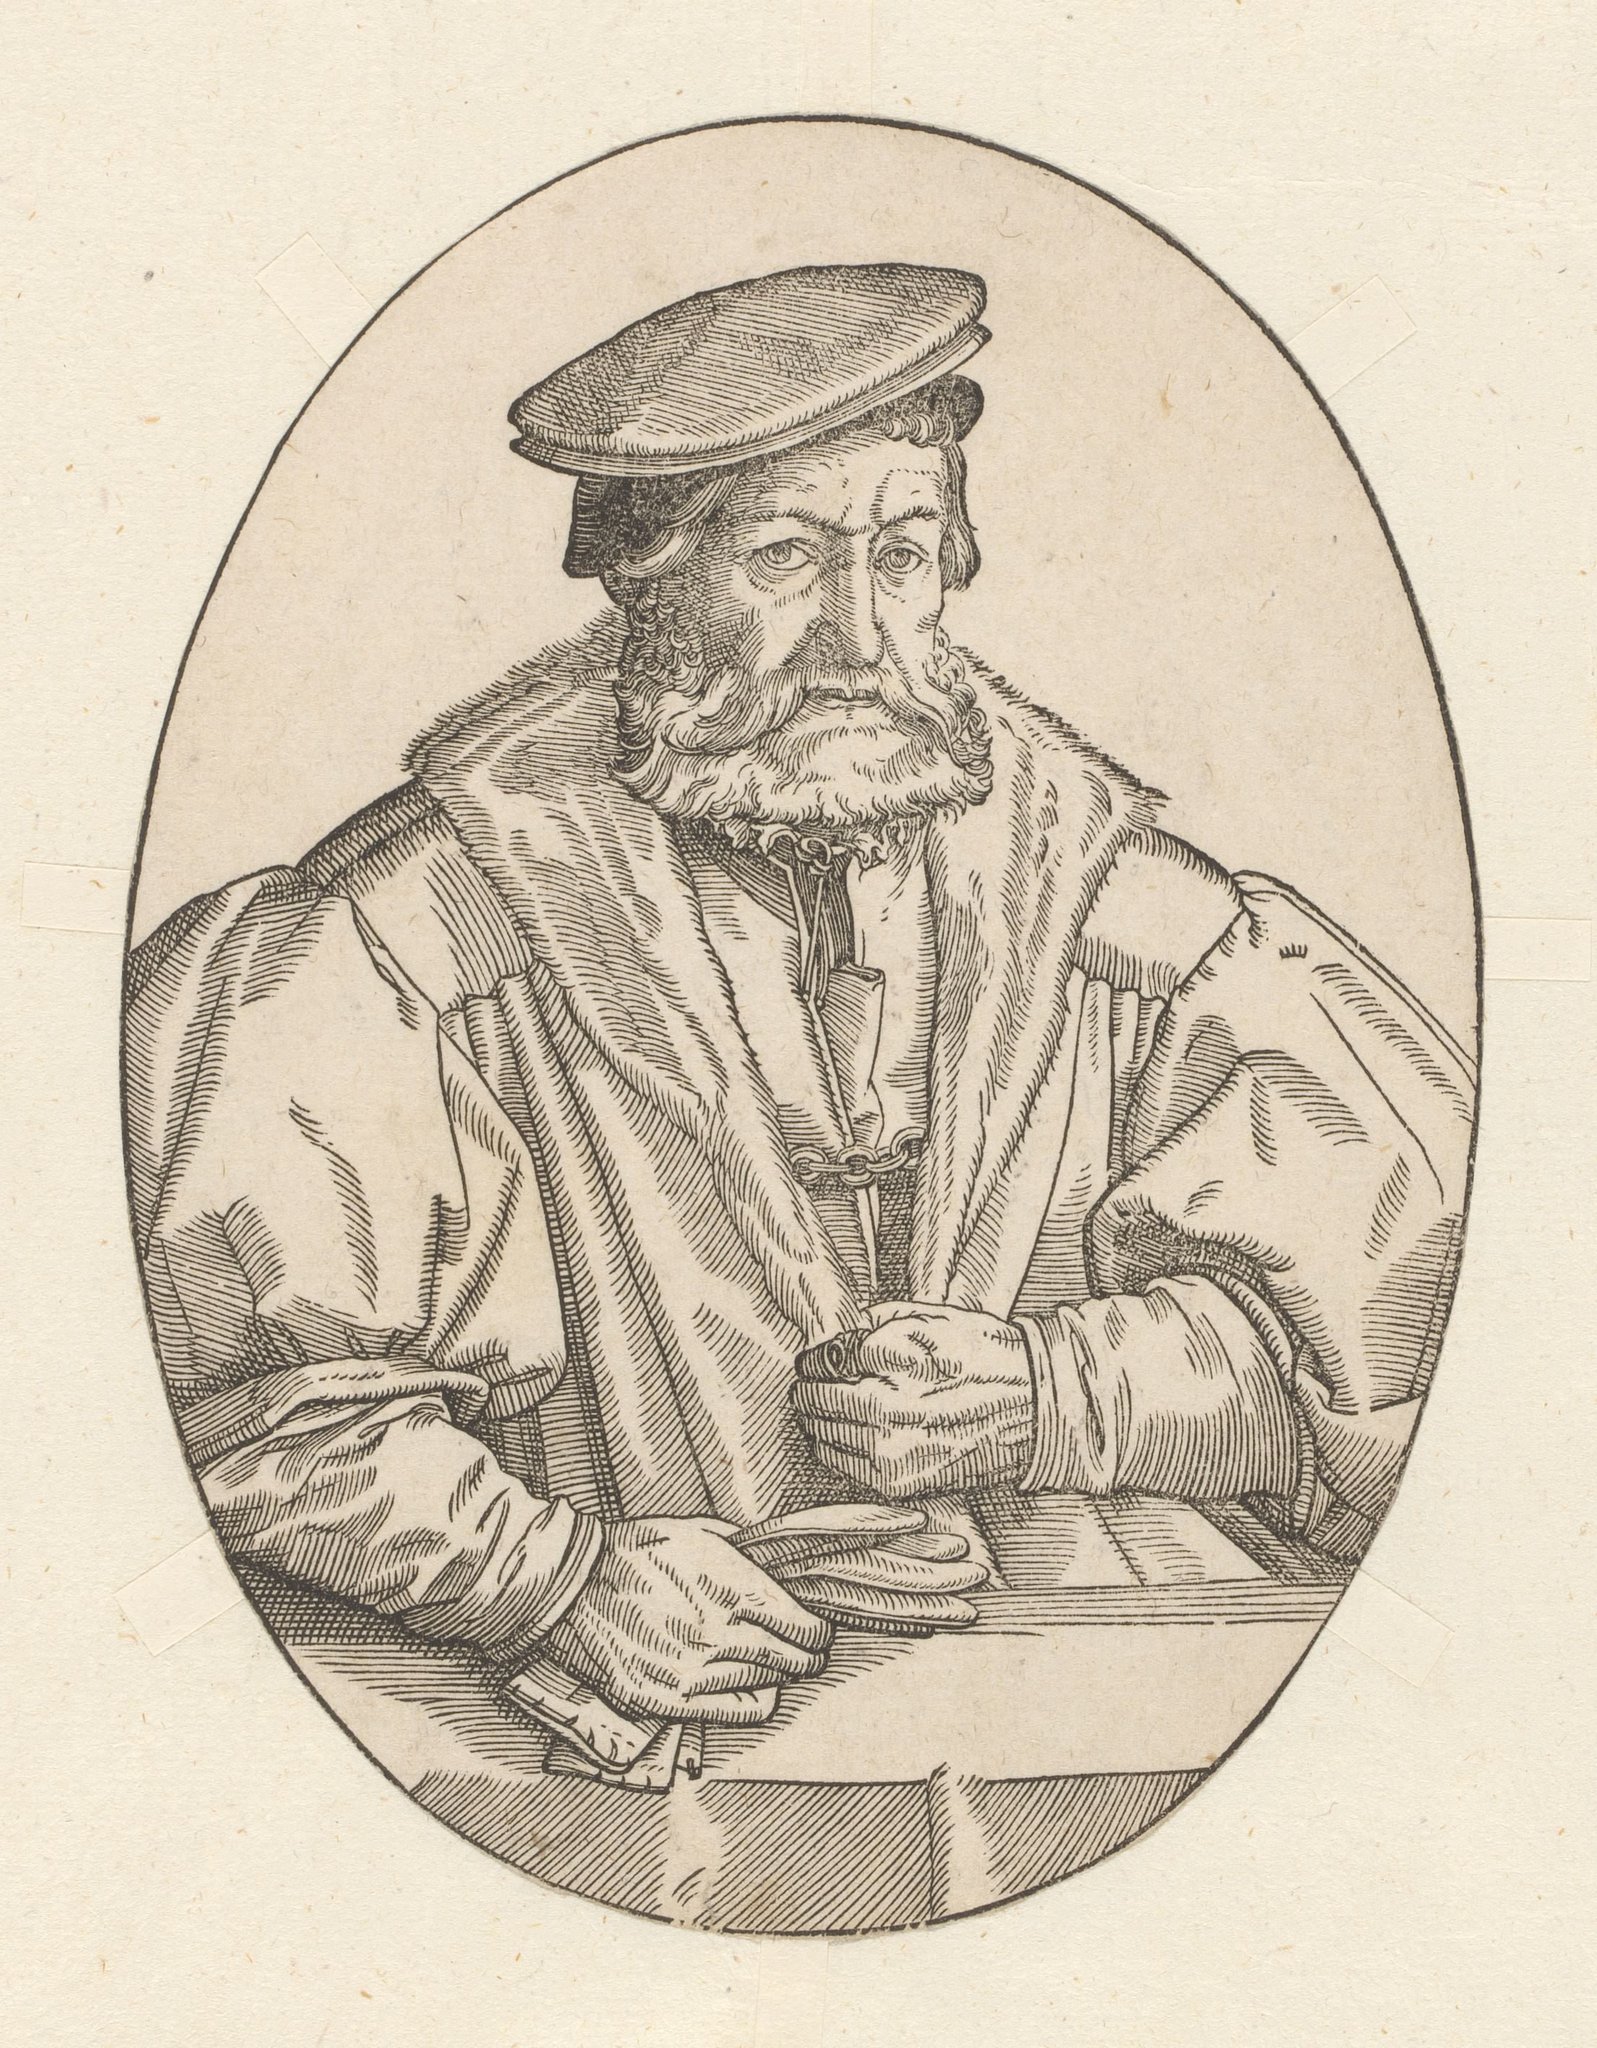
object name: album leaf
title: Portret van Johann Sturm op 63-jarige leeftijd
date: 1570-1584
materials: paper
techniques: woodcut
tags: historical persons